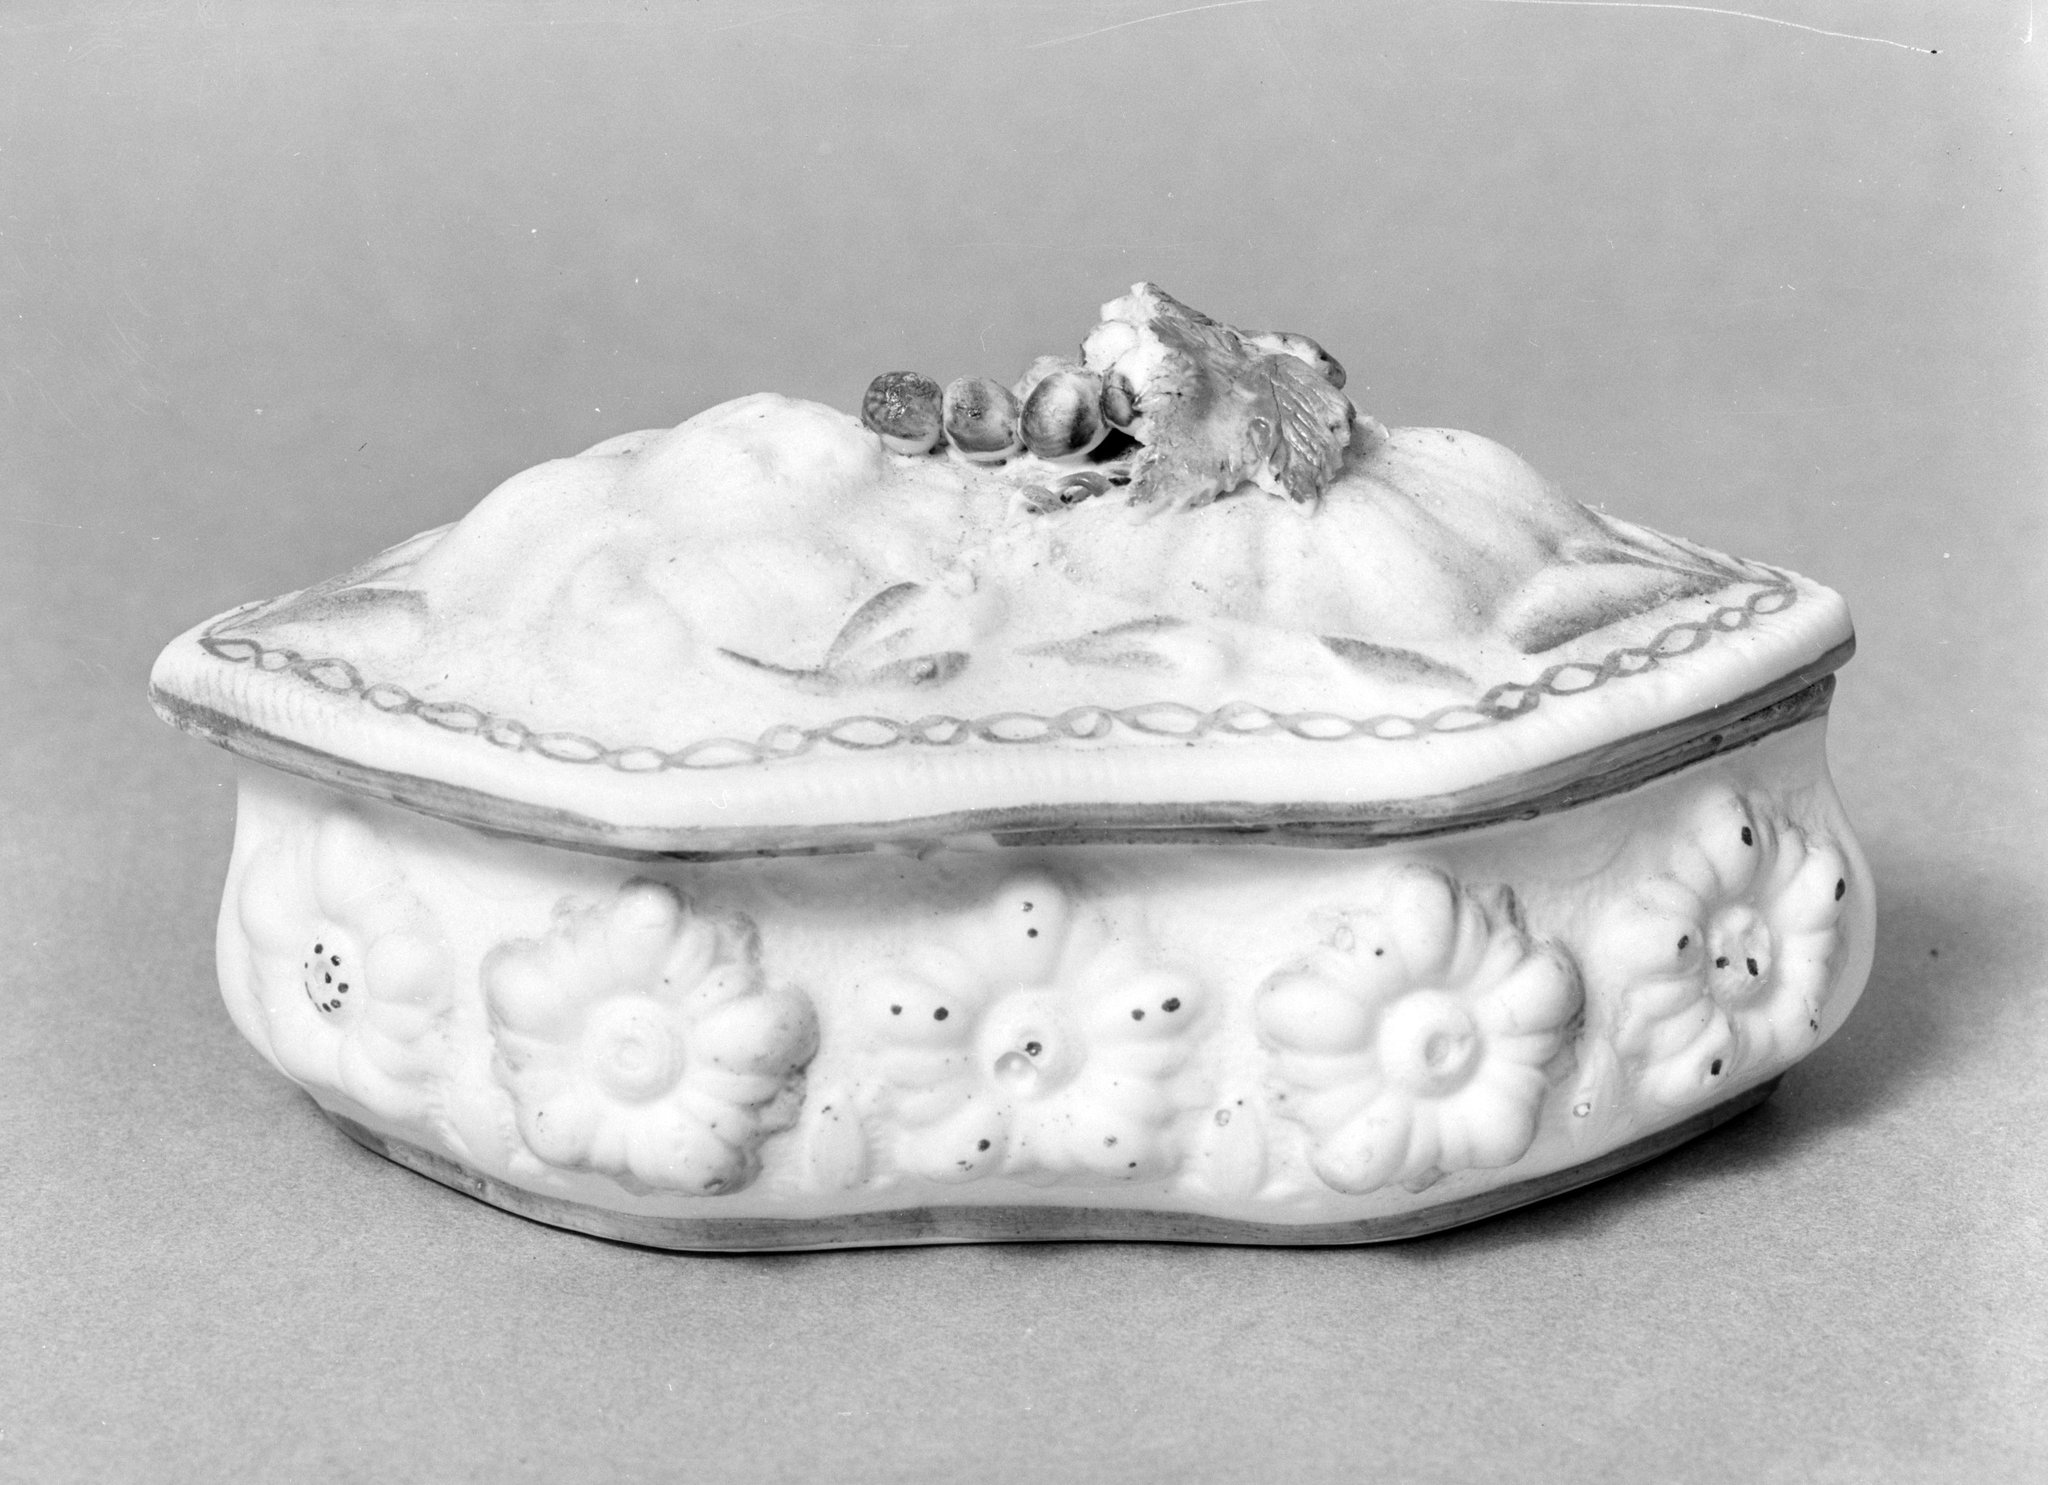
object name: box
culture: american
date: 1830-1870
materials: porcelain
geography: united states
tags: flowers